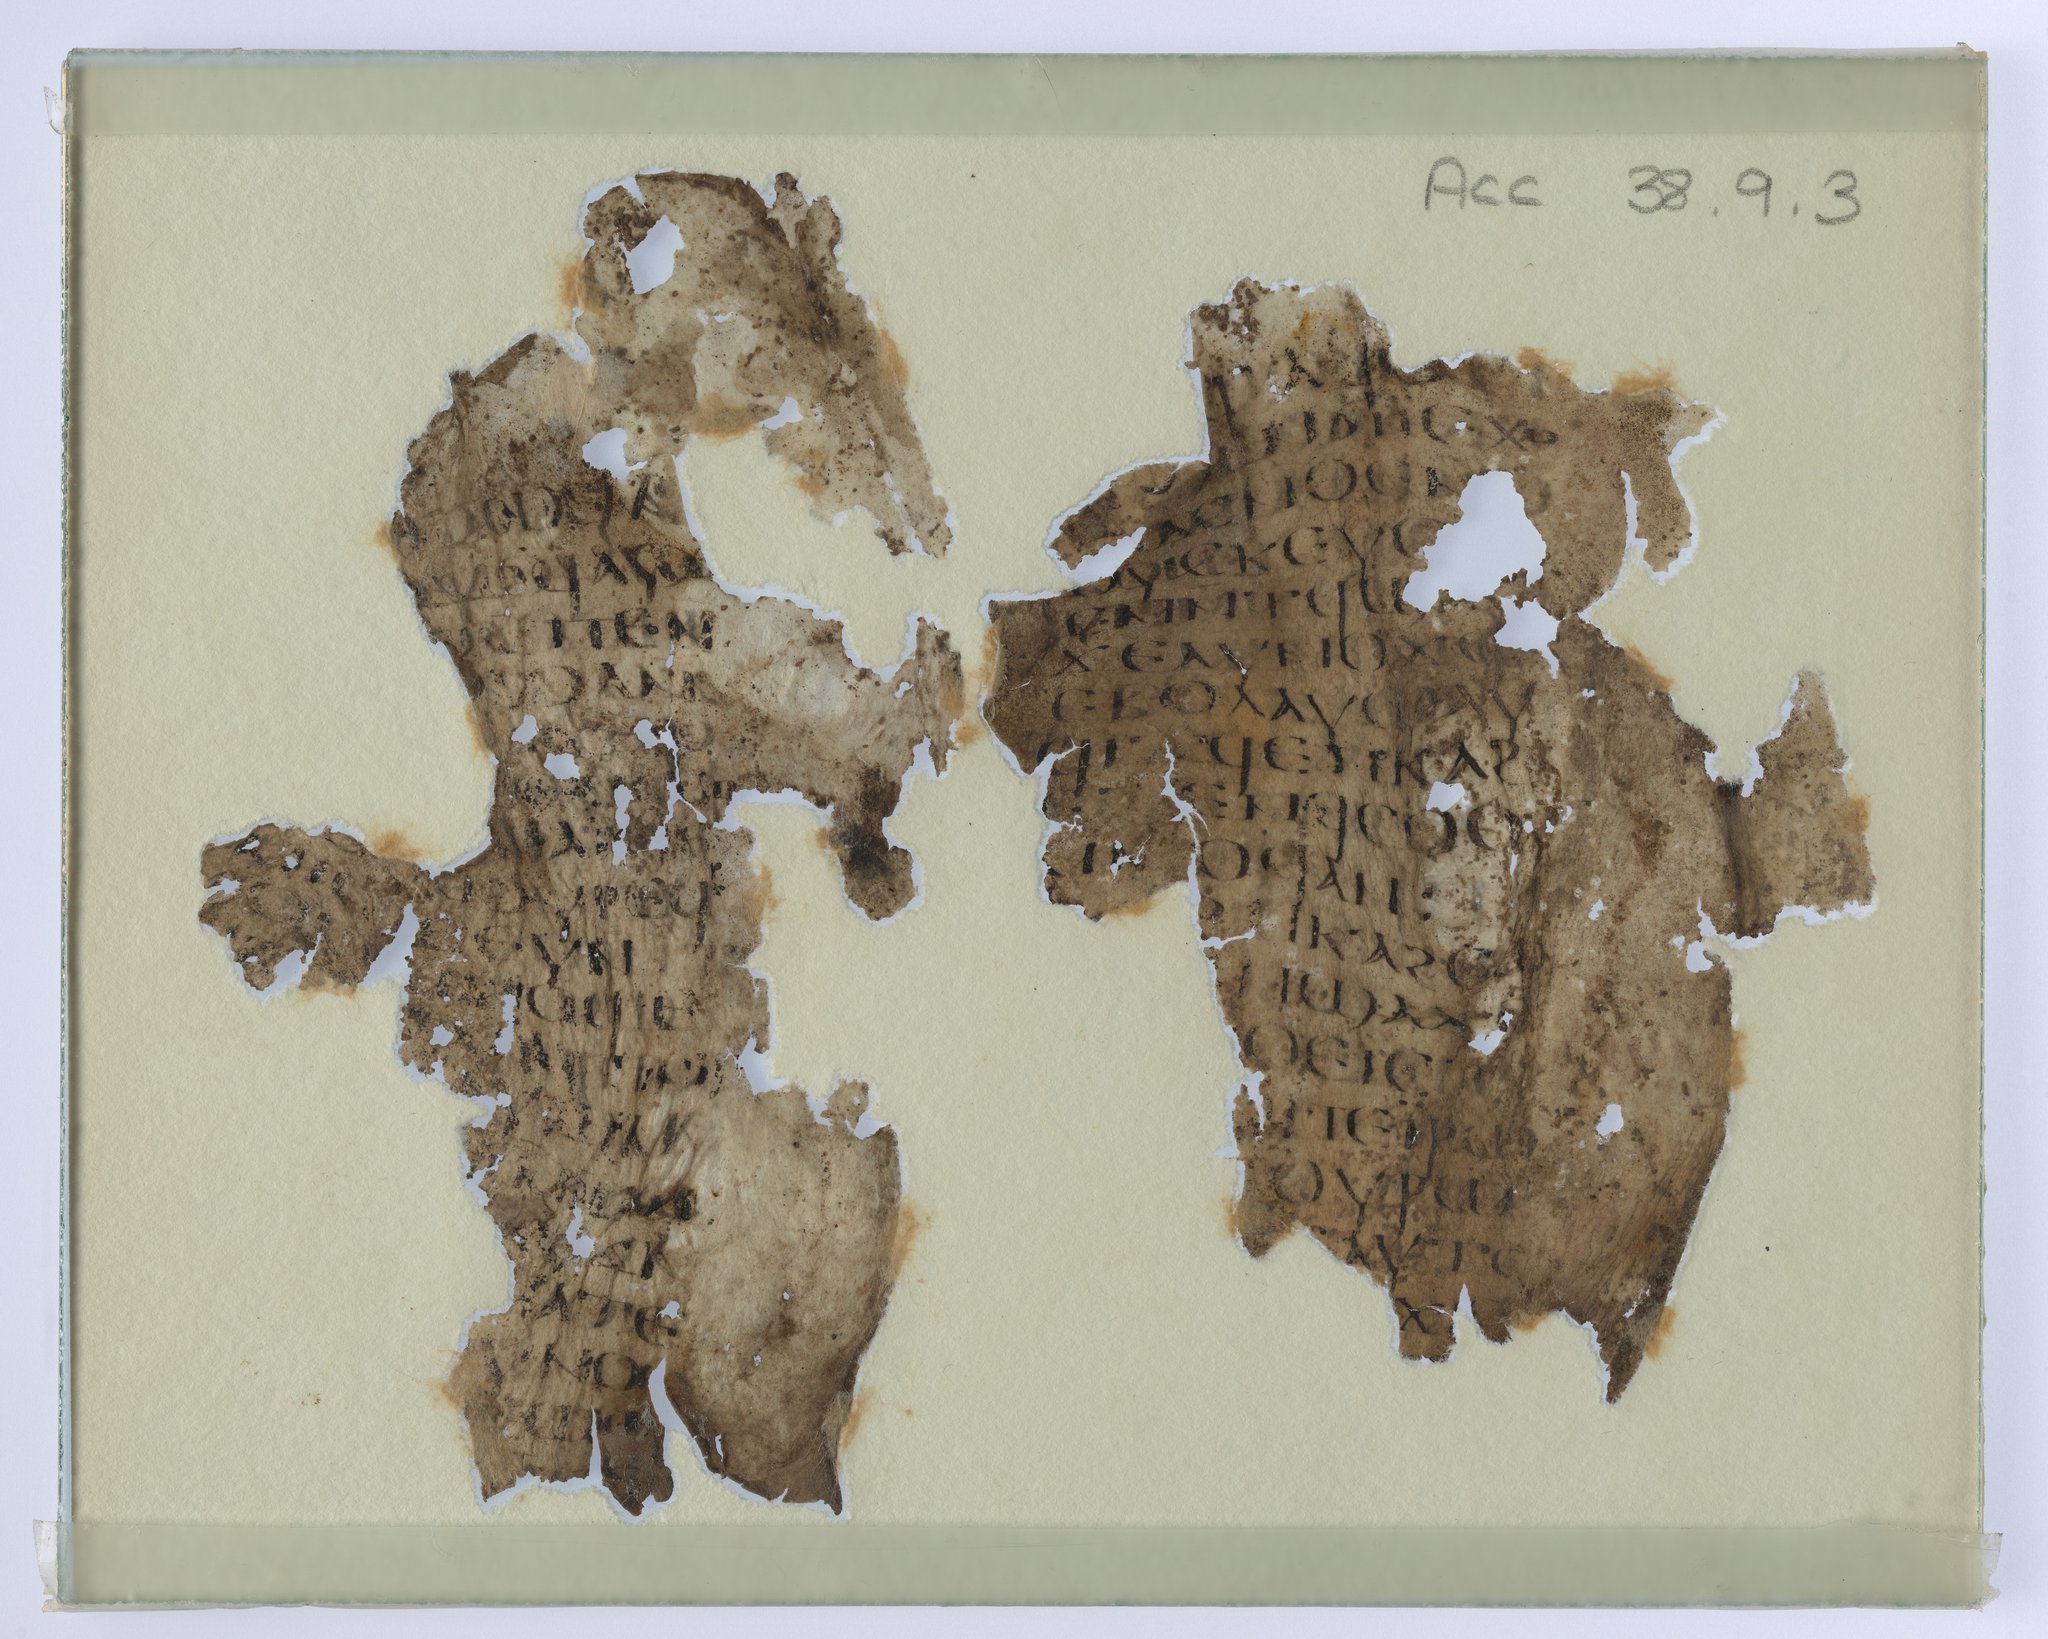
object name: manuscript leaf fragment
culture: coptic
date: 301-700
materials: ink, parchment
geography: egypt